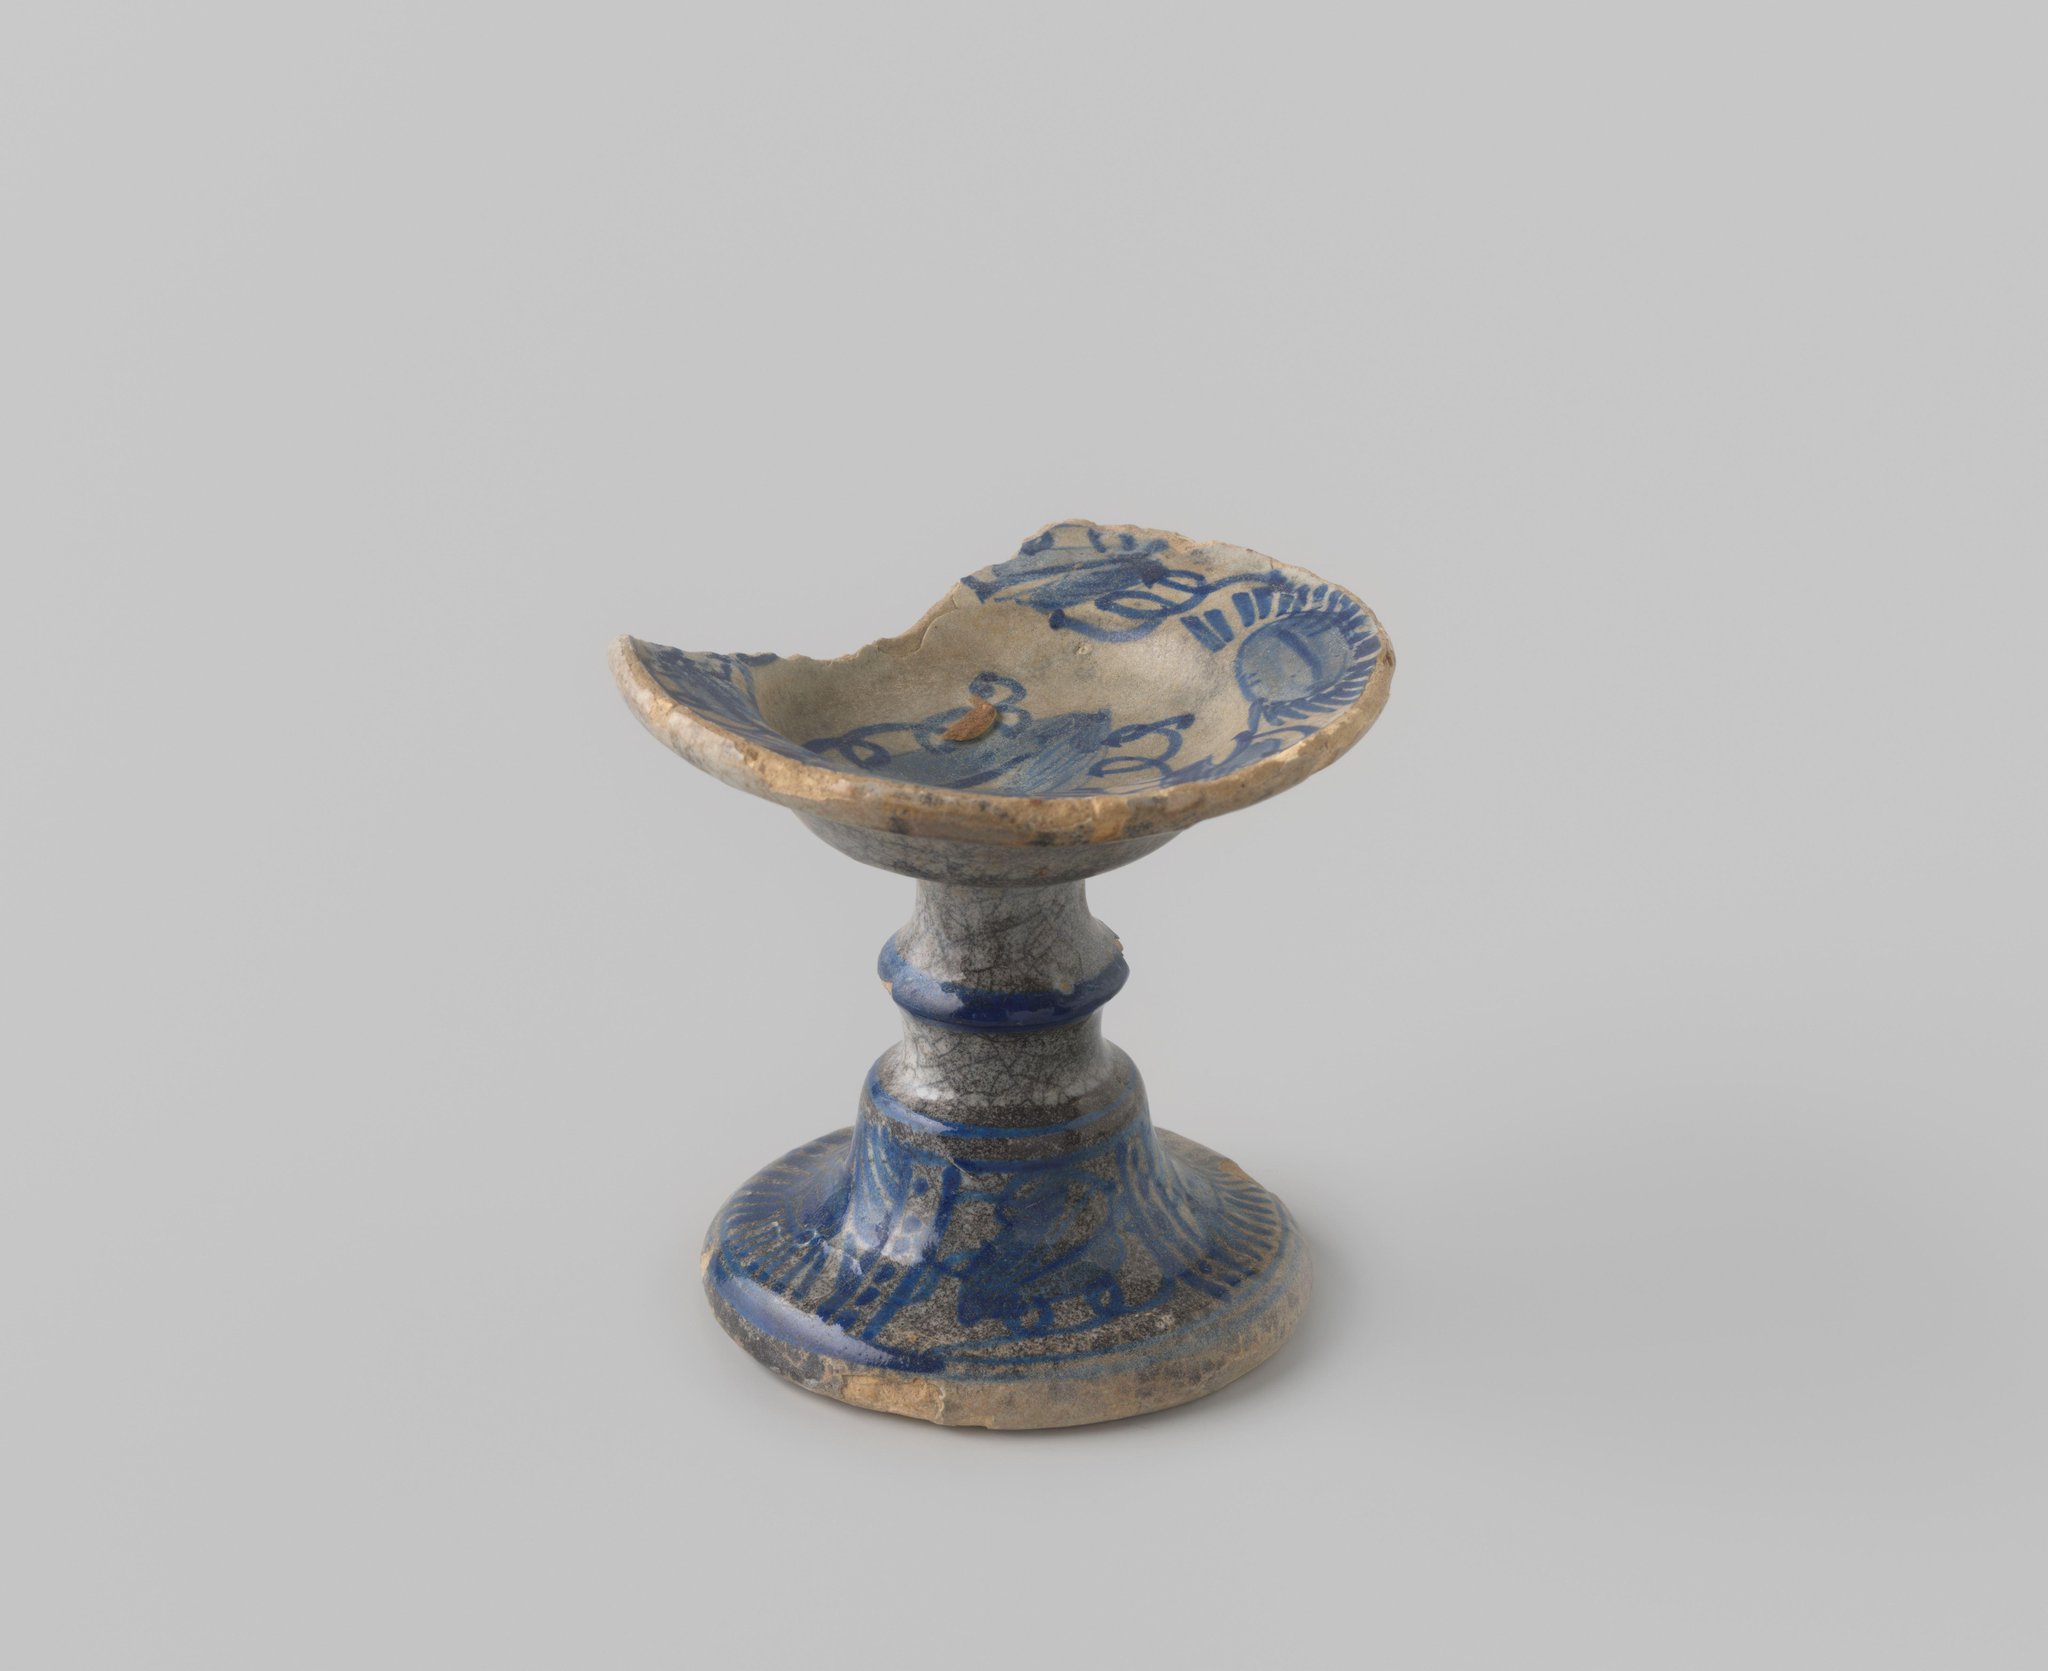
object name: salt condiment vessel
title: Zoutvat, beschilderd in blauw met gestileerde bloemen (Wan-li), beschadigd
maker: Anonymous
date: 1625-1650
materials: earthenware, glaze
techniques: maiolica, painted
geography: netherlands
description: Rond zoutvat op een voet, van blauw beschilderde majolica. Op het plat van de schaal is een gestileerde bloem geschilderd (Wan-Li) evenals op de wand en op de voet vier vakken waarbinnen een gestileerde bloem (Wan-Li).